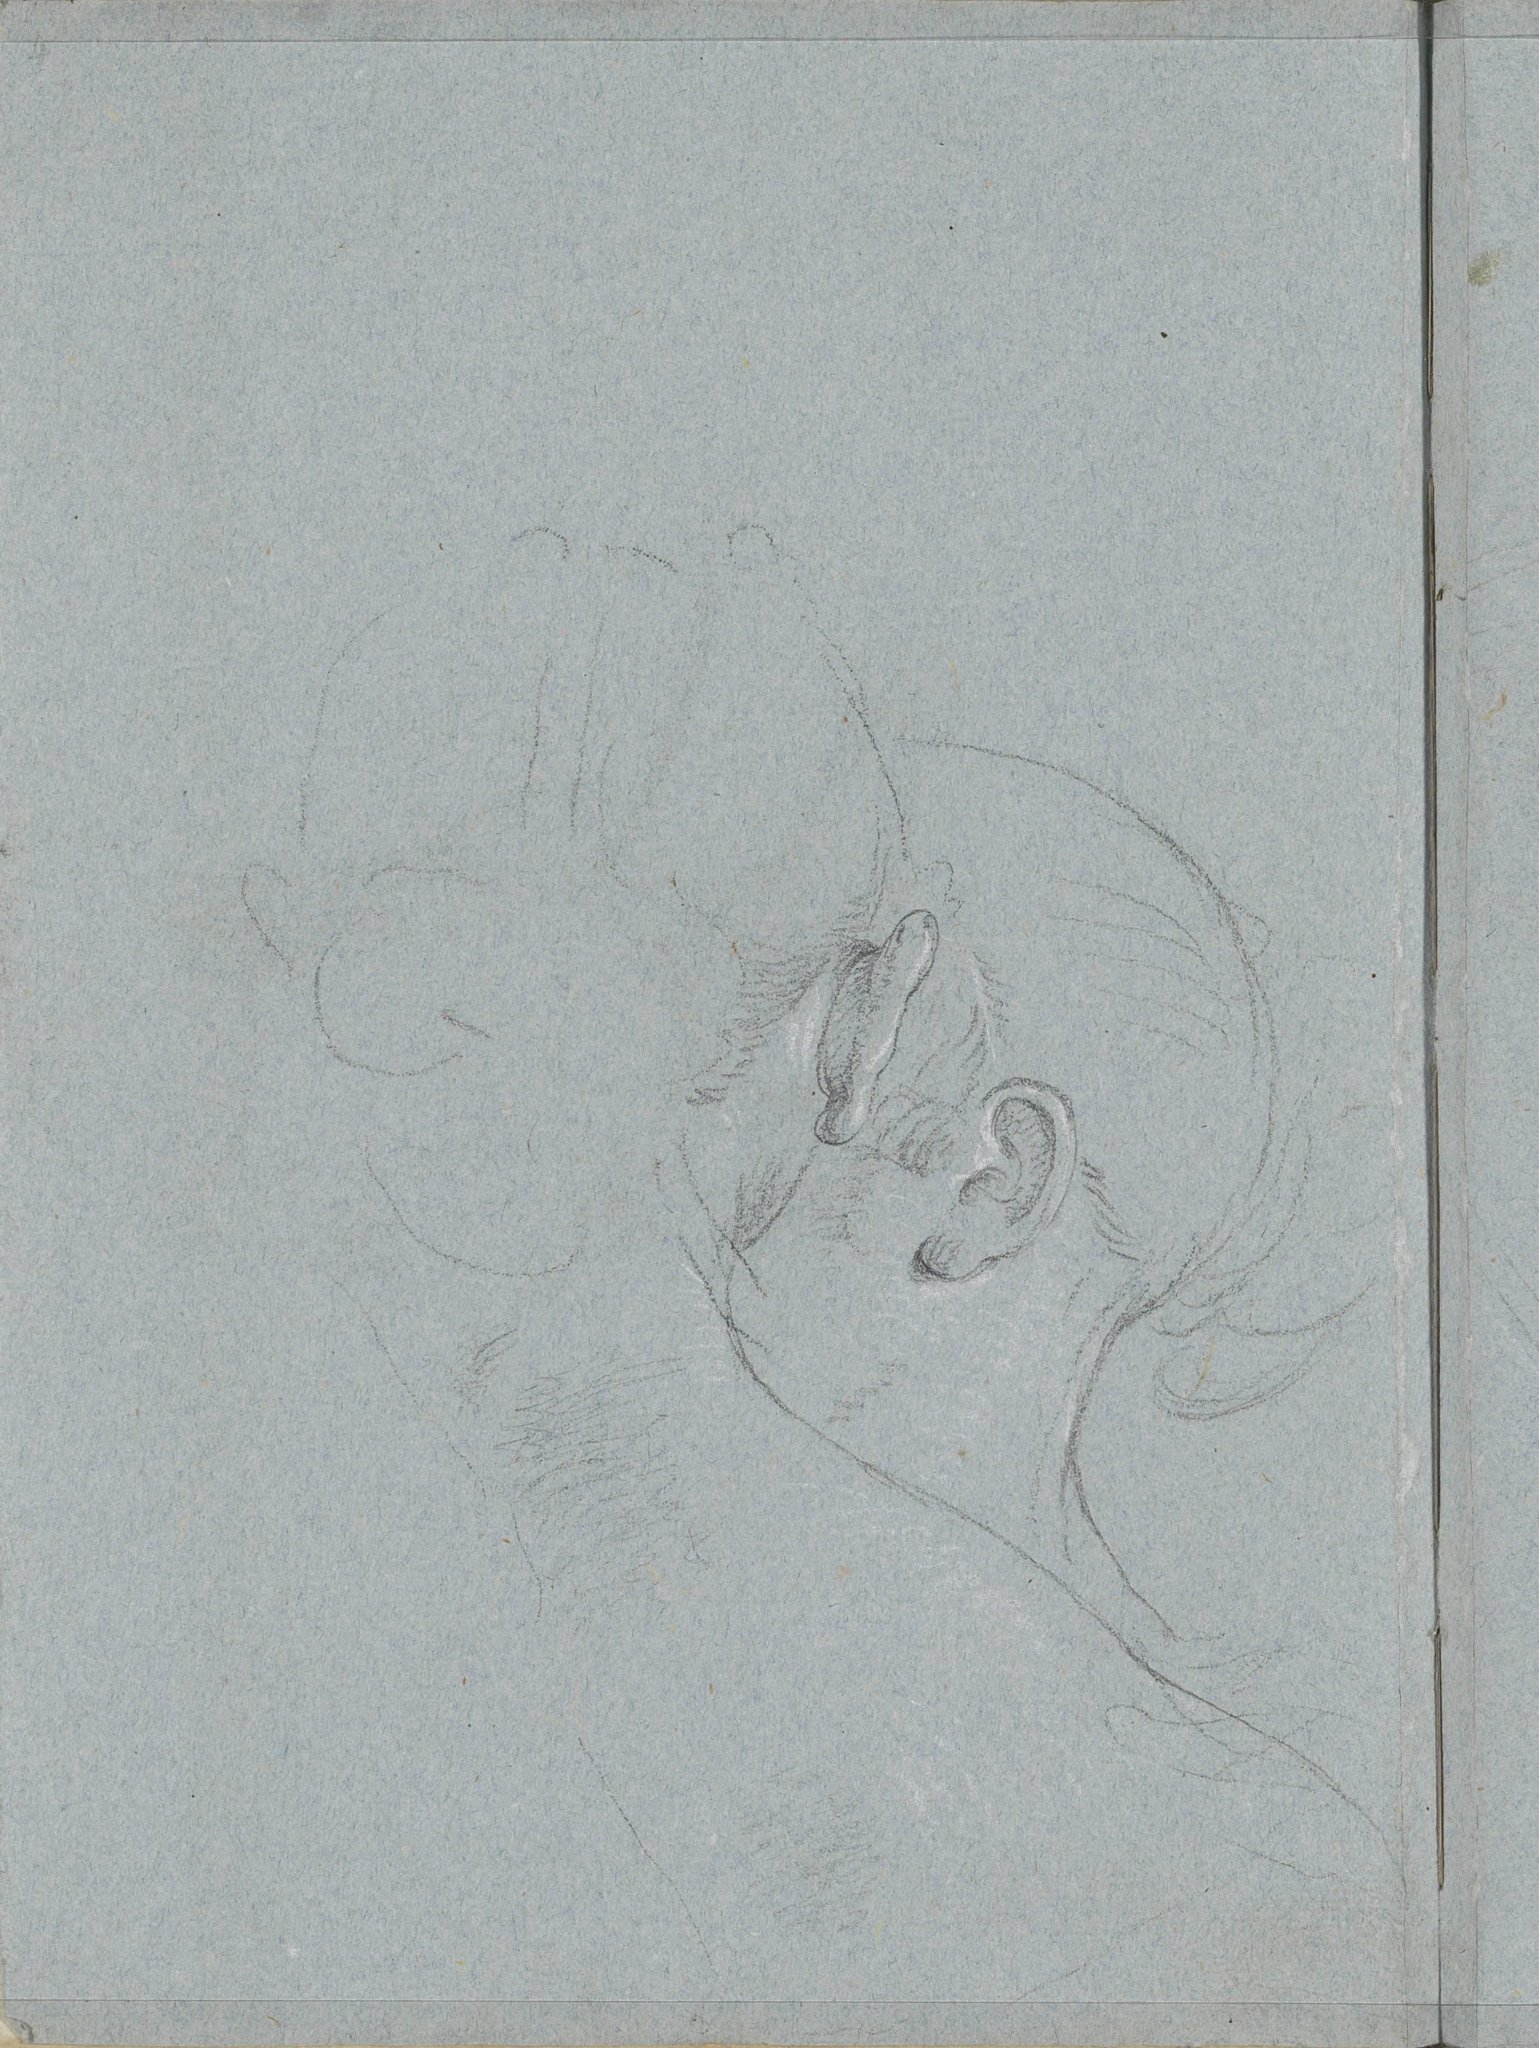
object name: sketchbook leaf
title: Twee hoofden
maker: lorenzo baldissera tiepolo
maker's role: draughtsman, print maker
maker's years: 1736-1776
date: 1751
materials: chalk, paper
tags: head (human) (+ sideview, profile), head (human) (+ back view)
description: Van achteren en opzij gezien. Bladzijde 4 uit een schetsboek met 158 bladzijden.